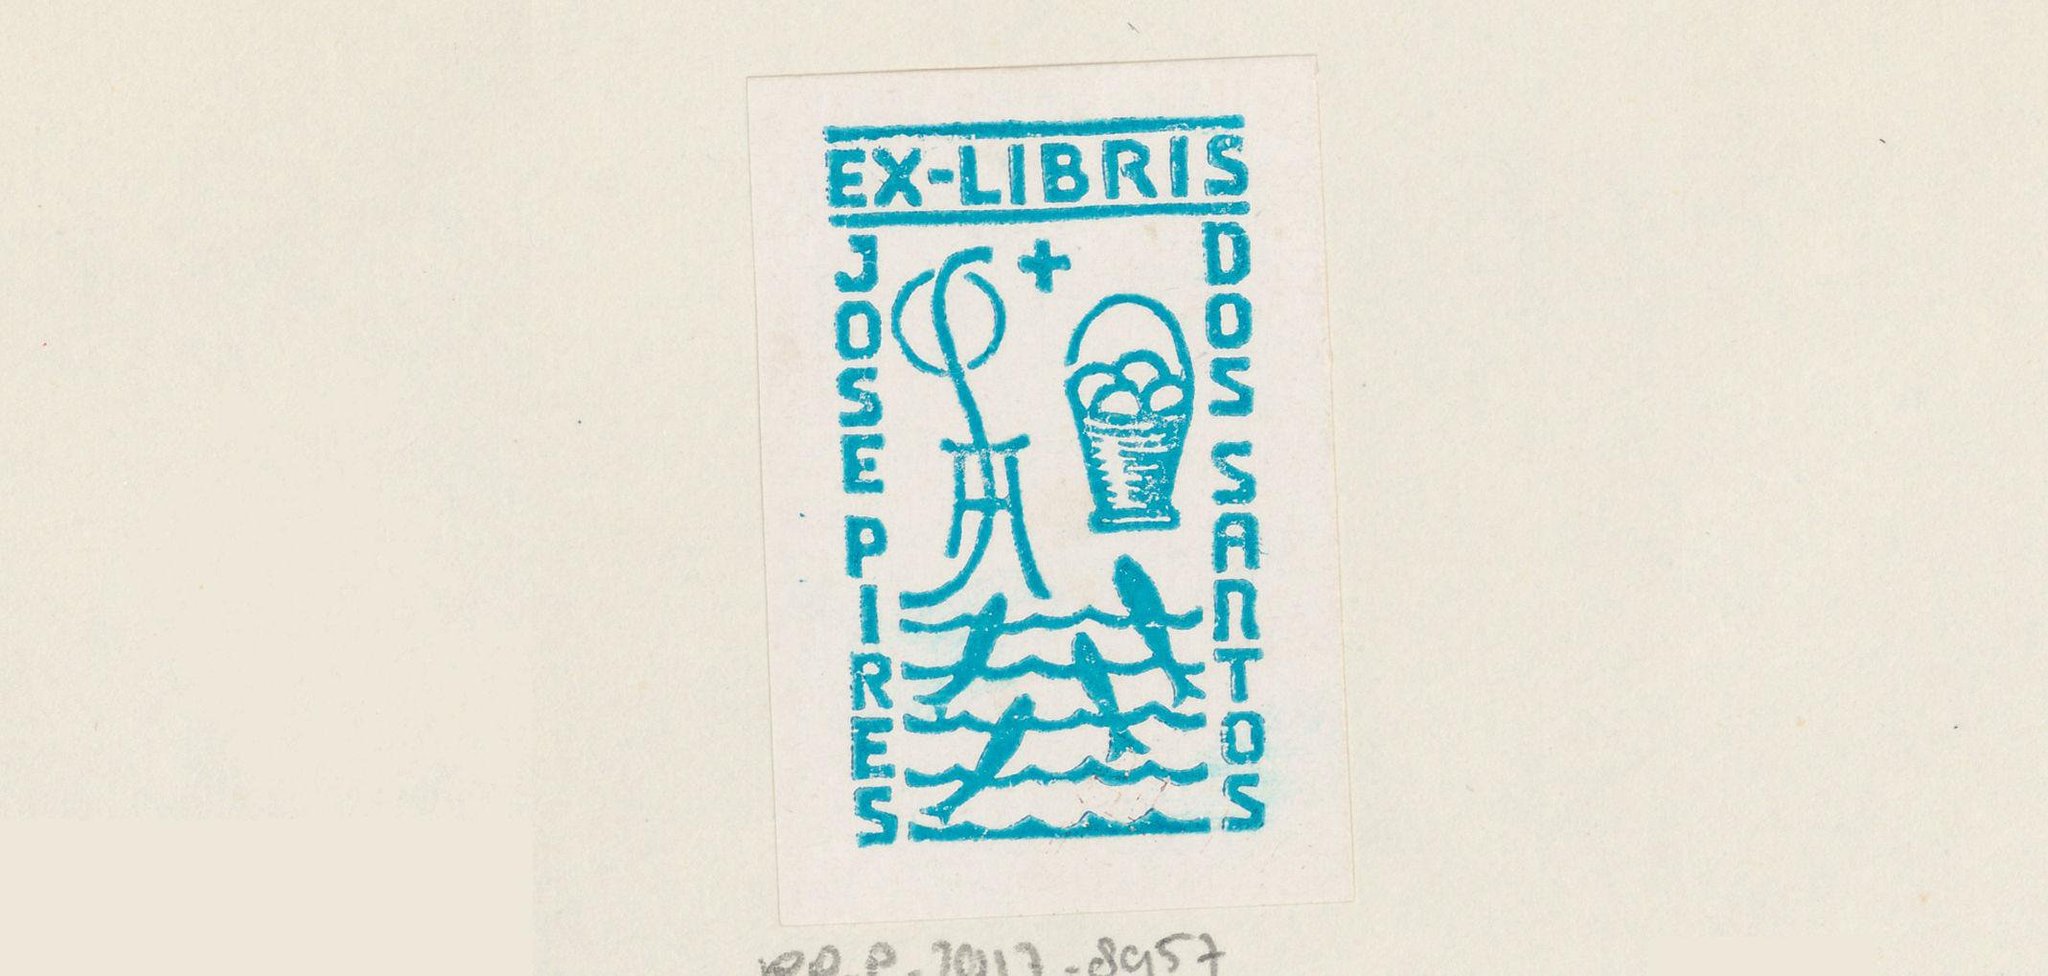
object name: bookplate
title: Ex libris van José Pires dos Santos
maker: Anonymous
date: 1900-1999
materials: paper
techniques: printing block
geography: north and central america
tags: fishes, container made of plant material other than wood: basket